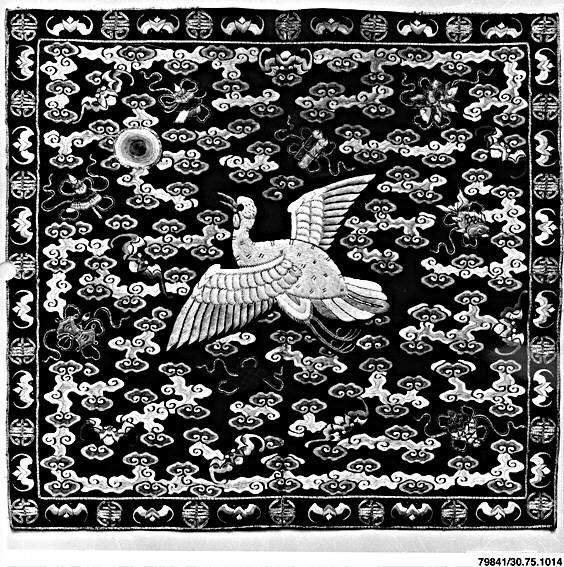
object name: rank badge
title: Rank Badge with Wild Goose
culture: chinese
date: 1767-1833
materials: silk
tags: bats,geese